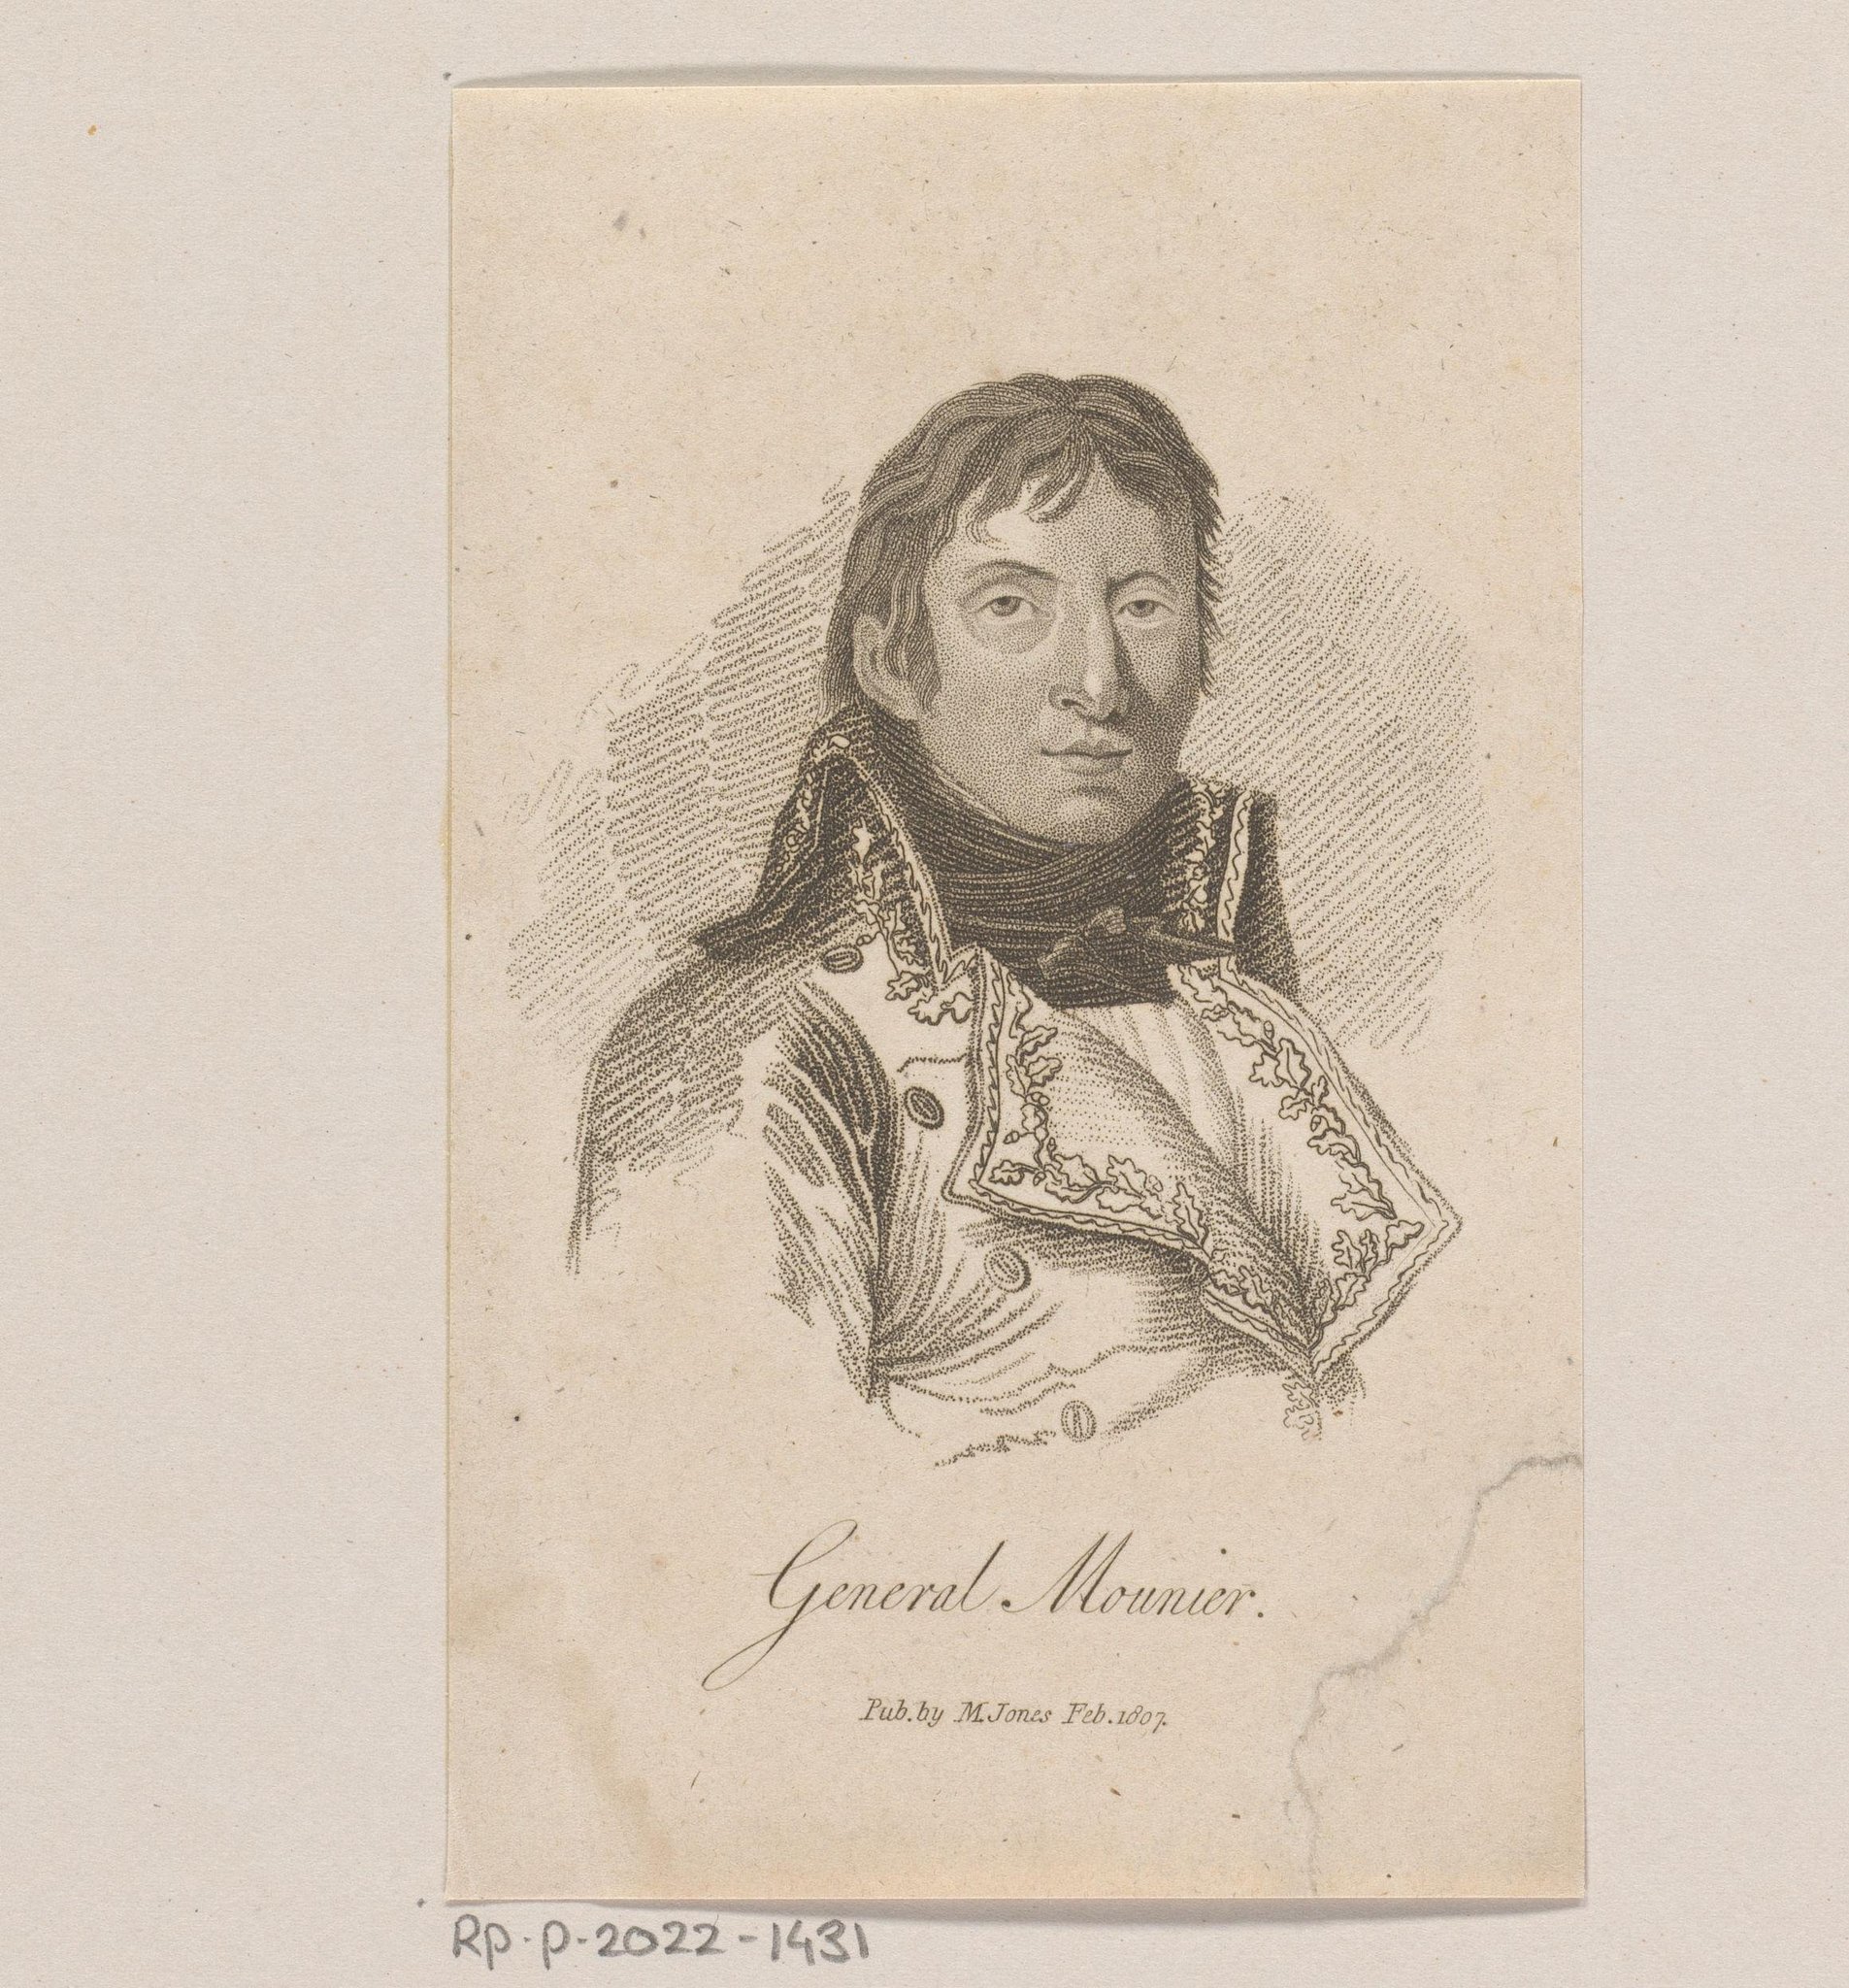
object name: print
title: Portret van Jean-Charles Monnier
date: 1802-1807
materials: paper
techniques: engraving, roulette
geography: london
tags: commander-in-chief, general, marshal, historical persons